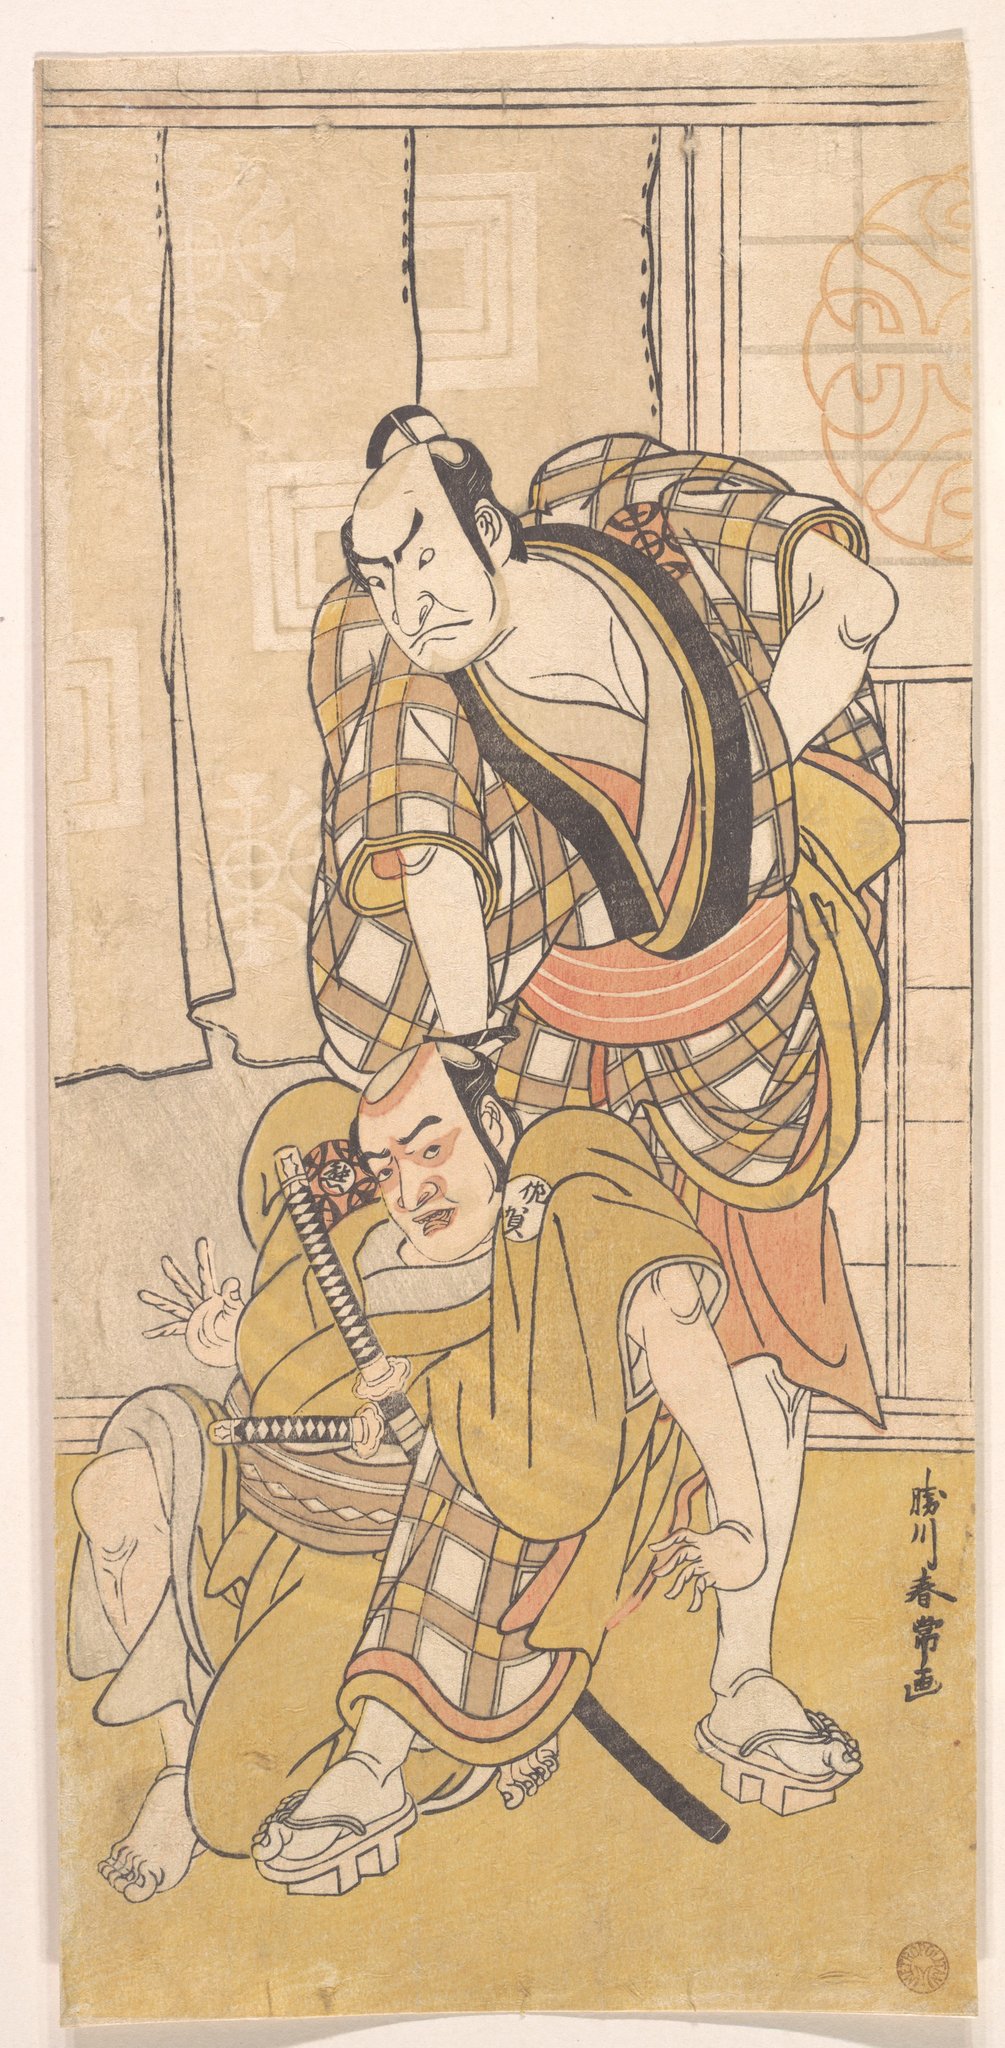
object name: print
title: Scene from a Play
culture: japanese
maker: katsukawa shunjō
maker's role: artist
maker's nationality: japanese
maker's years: 1700-1787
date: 1780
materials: ink, paper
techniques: woodblock print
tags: men,actors